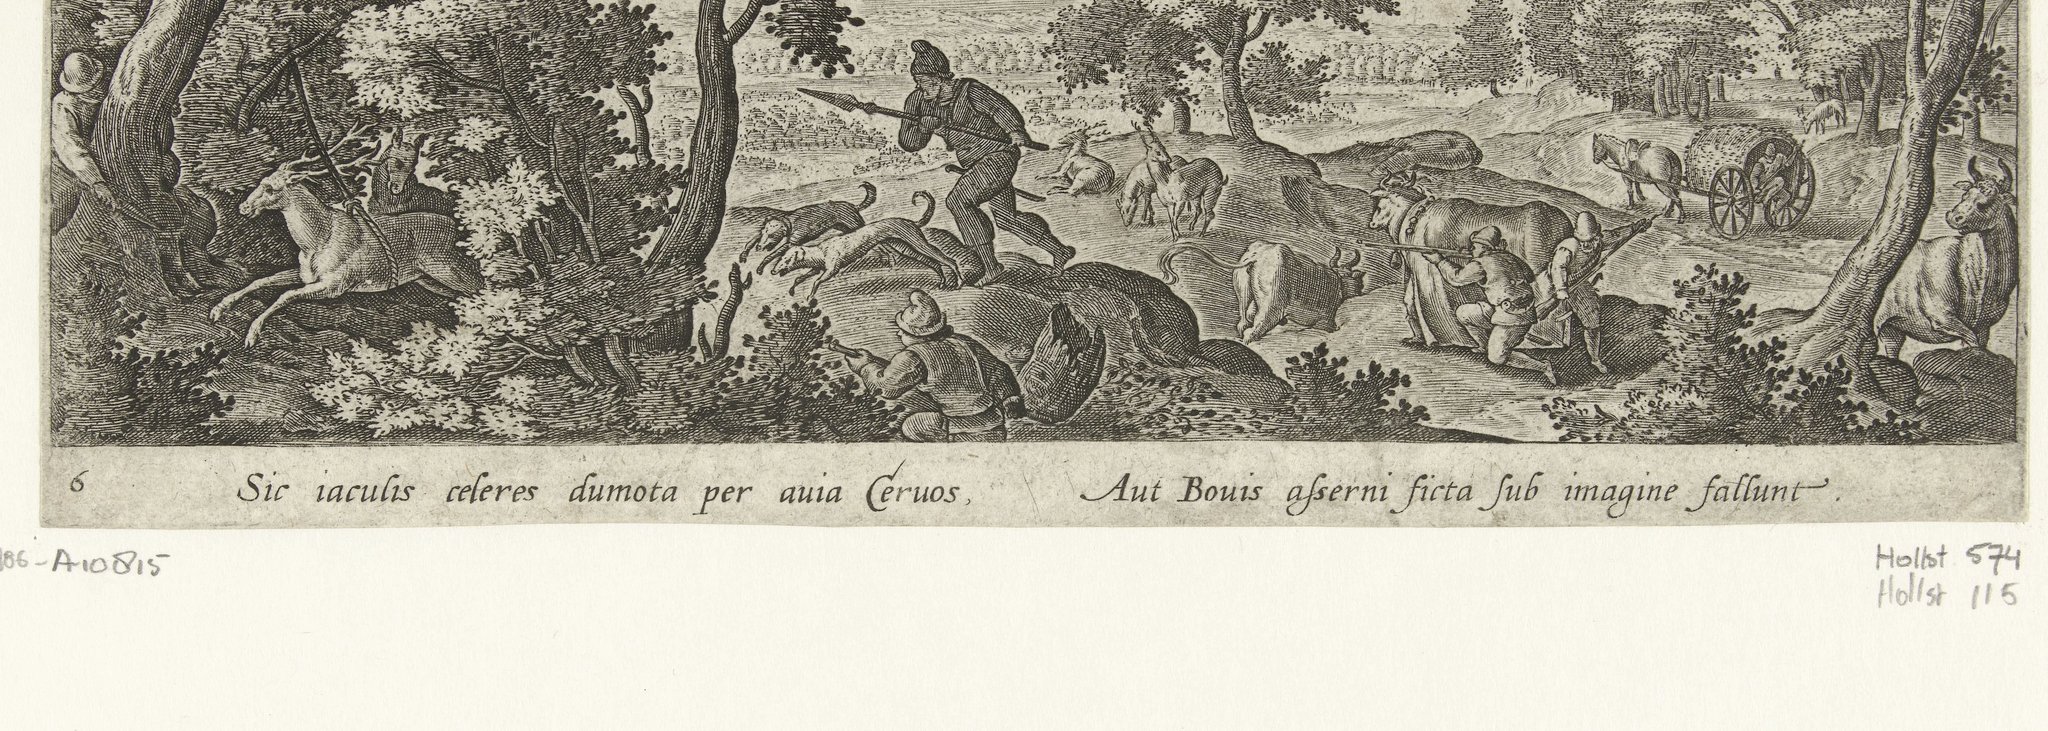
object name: print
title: Hertenjacht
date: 1582-1636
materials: paper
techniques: engraving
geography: antwerp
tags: roe-hunting (+ hunting with dogs)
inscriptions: collector's mark: Lugt 2228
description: Enkele jagers achtervolgen een hert en jagen het op met behulp van honden. In de achtergrond wordt met geweren op herten gejaagd. De prent heeft een Latijns onderschrift en maakt deel uit van een serie van 54 prenten.